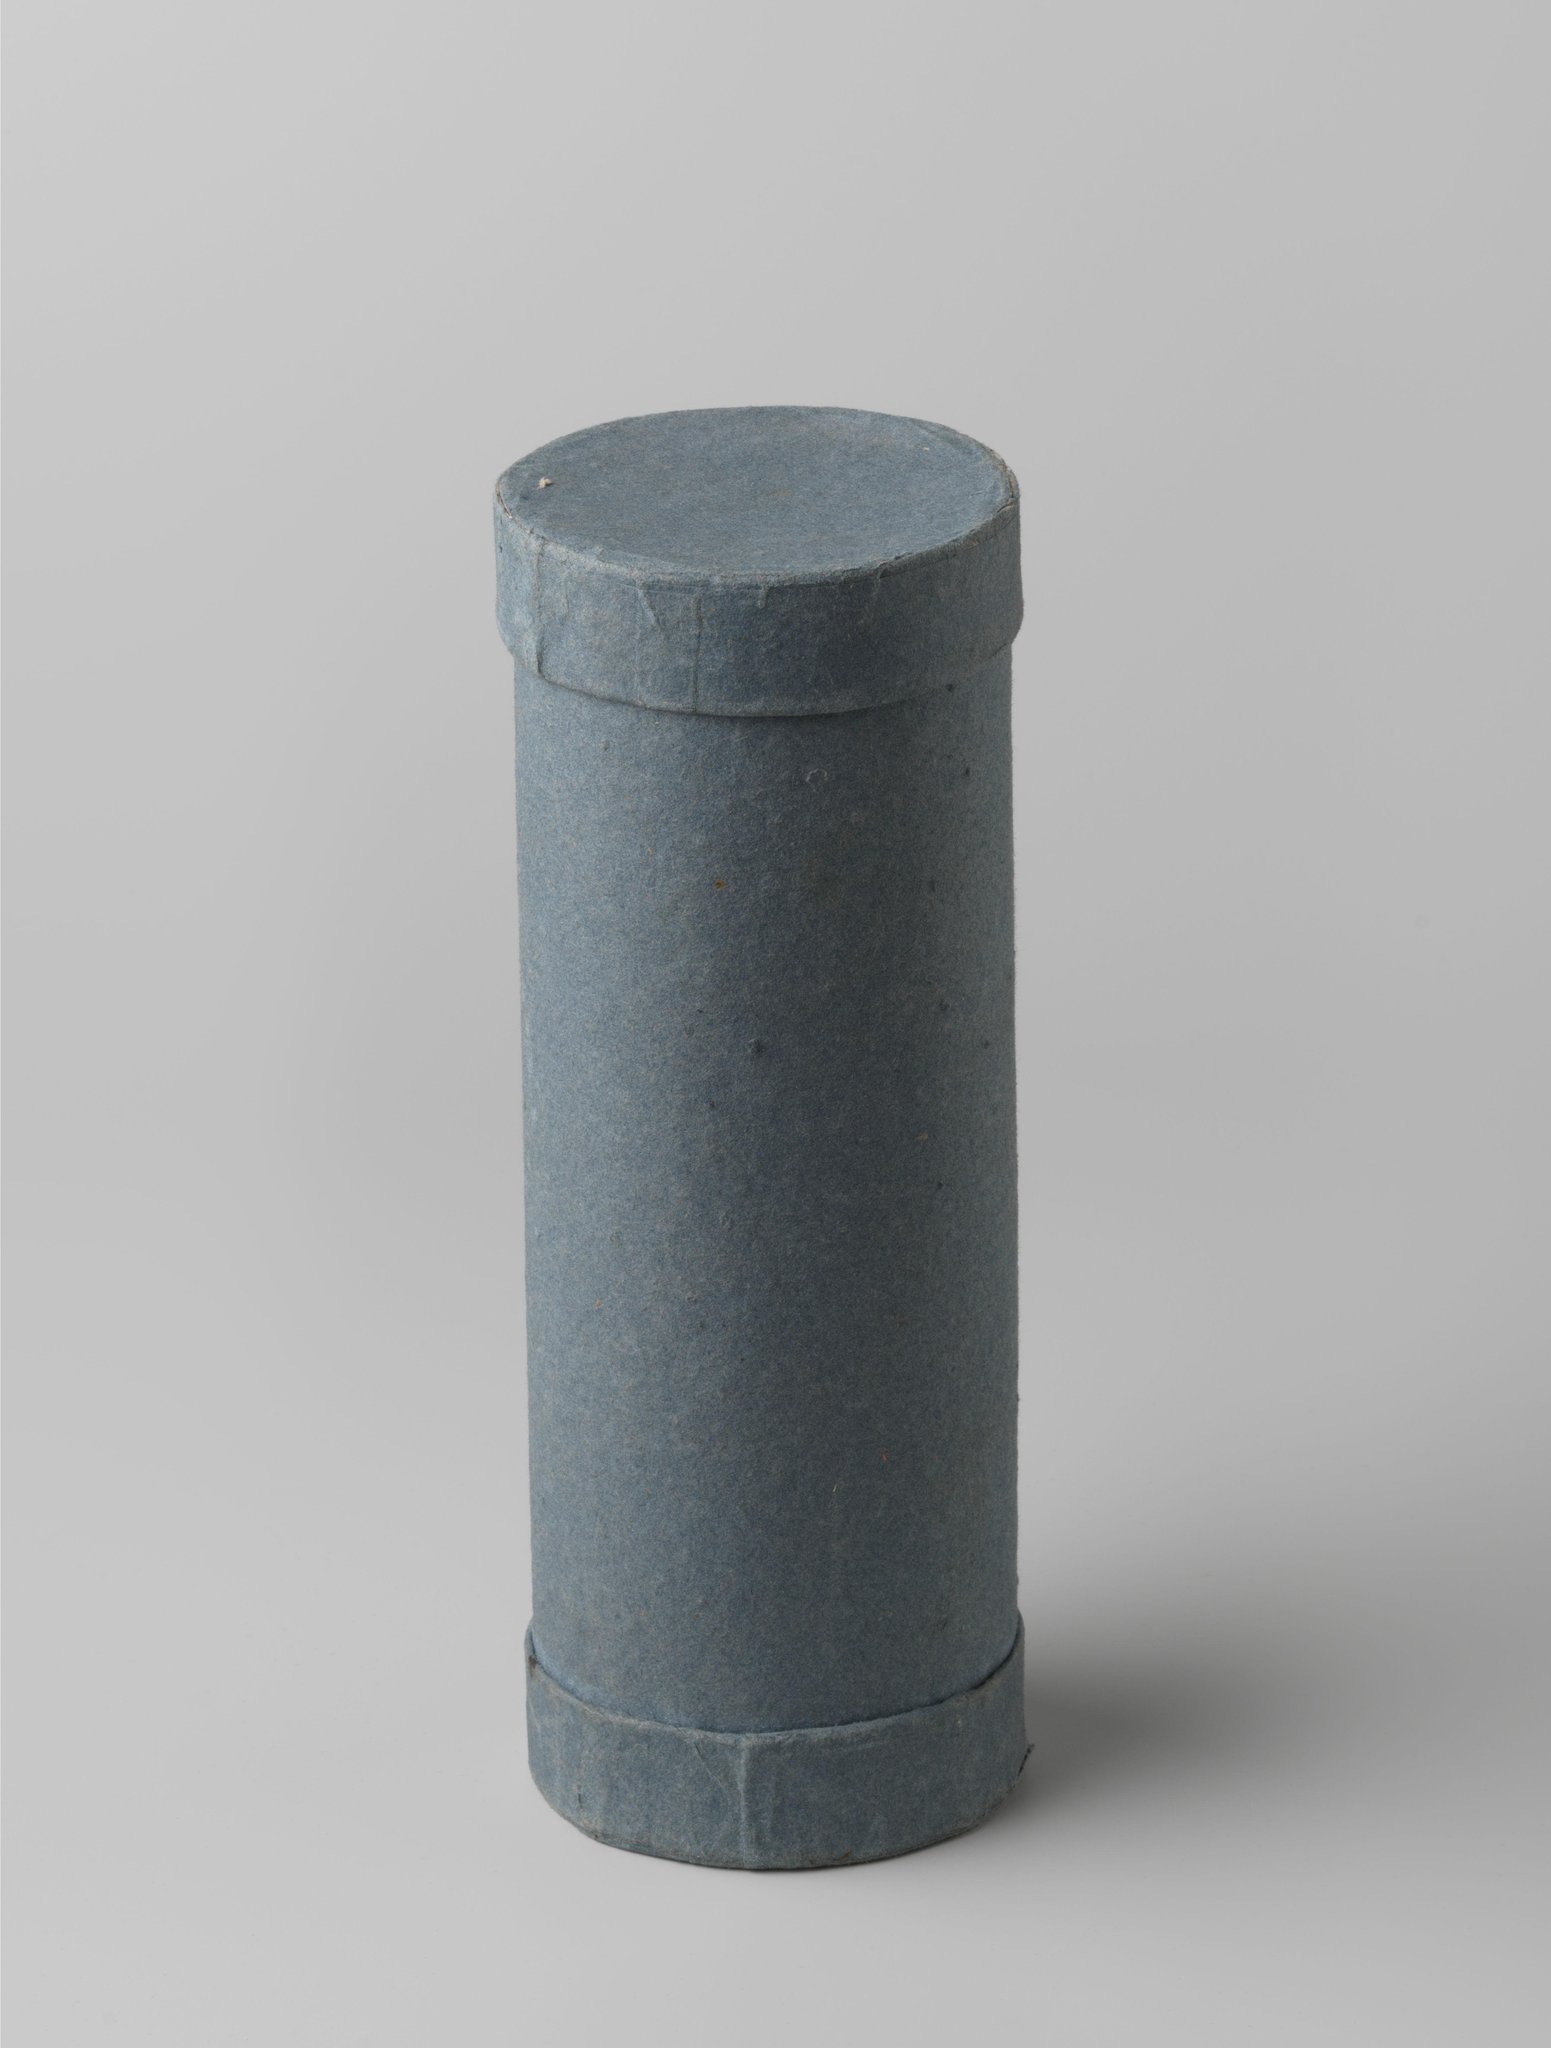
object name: packing material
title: Pluimkoker van blauw karton bestemd voor de berging van een pluim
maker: isaäc johannes froger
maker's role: hoedenmaker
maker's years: 1781-1843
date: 1810-1840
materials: cardboard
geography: amsterdam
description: Pluimkoker van blauw karton bestemd voor de berging van een pluim.